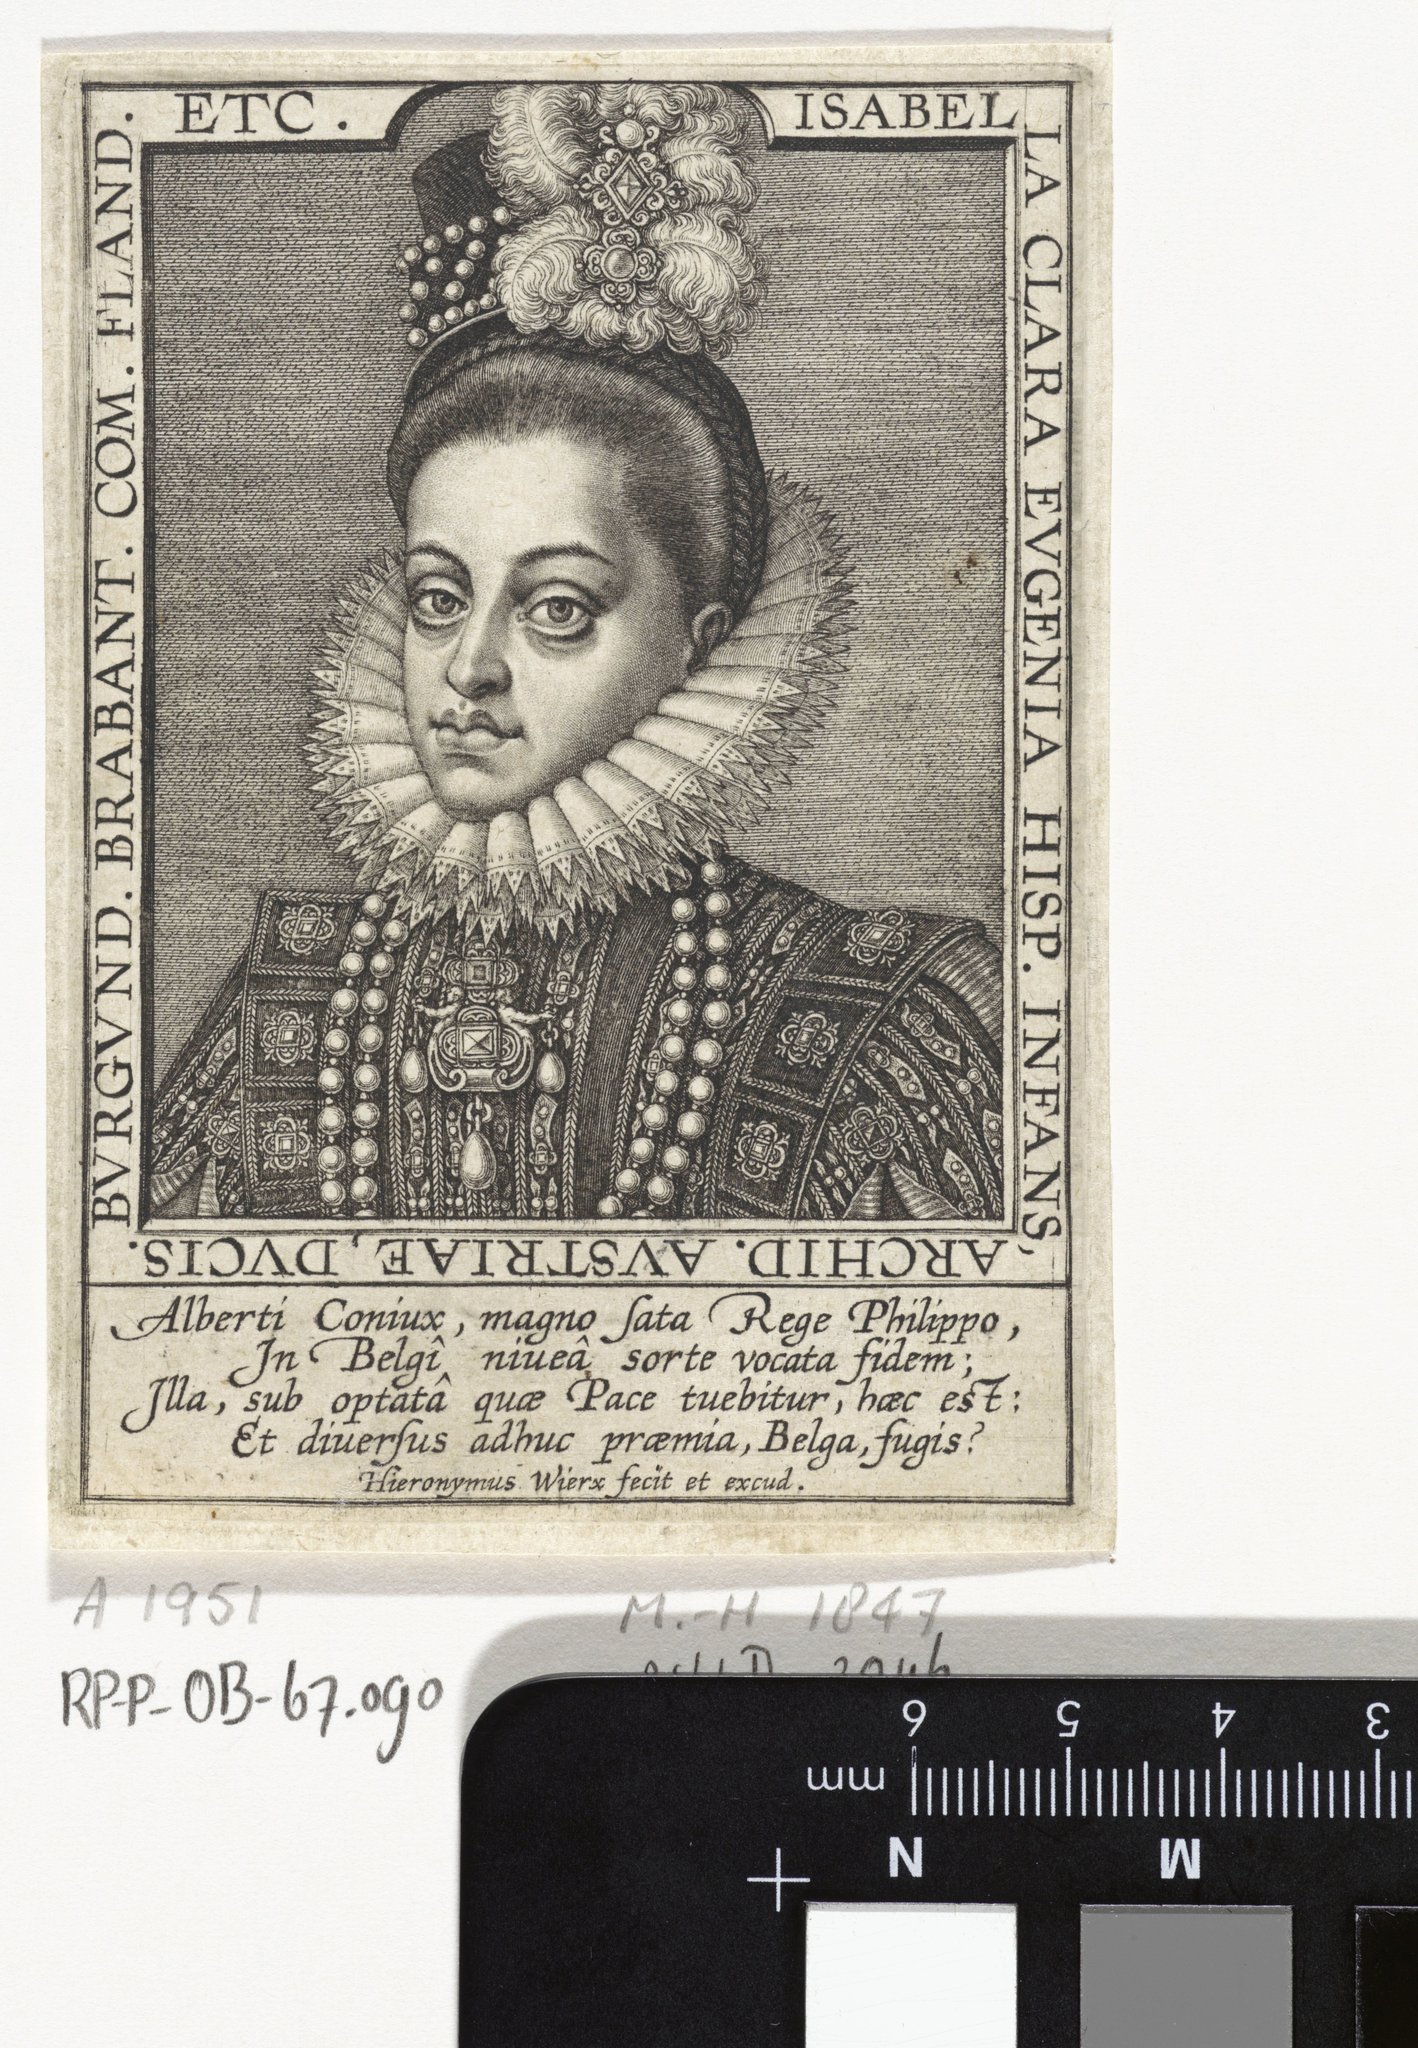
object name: print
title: Portret van Isabella Clara Eugenia, infante van Spanje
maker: hieronymus wierix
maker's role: draughtsman, print maker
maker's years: 1553-1619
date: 1598-1619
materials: paper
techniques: engraving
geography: antwerp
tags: infante van spanje isabella clara eugenia, brooch, agraffe, clasp (+ women's clothes), head-gear, neck-gear ~ clothing (with name) (+ fur used for clothes)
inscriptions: number: ‘22. - 23.’, collector's mark: Lugt 2228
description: Busteportret van Isabella Clara Eugenia, infante van Spanje Albrecht en gemalin van aartshertog van Oostenrijk. Ze draagt een rijk versierde hoed en jurk met juwelen. De voorstelling is gevat in een omlijsting met een randschrift in het Latijn. In de marge een vierregelig onderschrift in het Latijn.